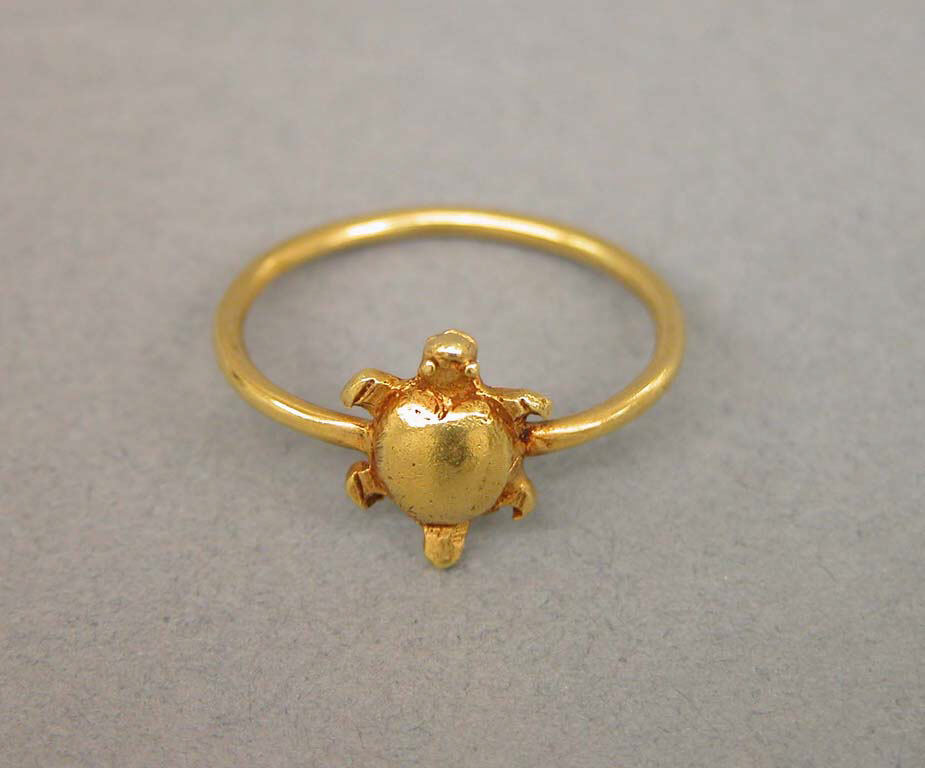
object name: ring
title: Ring with Tortoise Motif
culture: indonesian, javanese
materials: gold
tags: animals